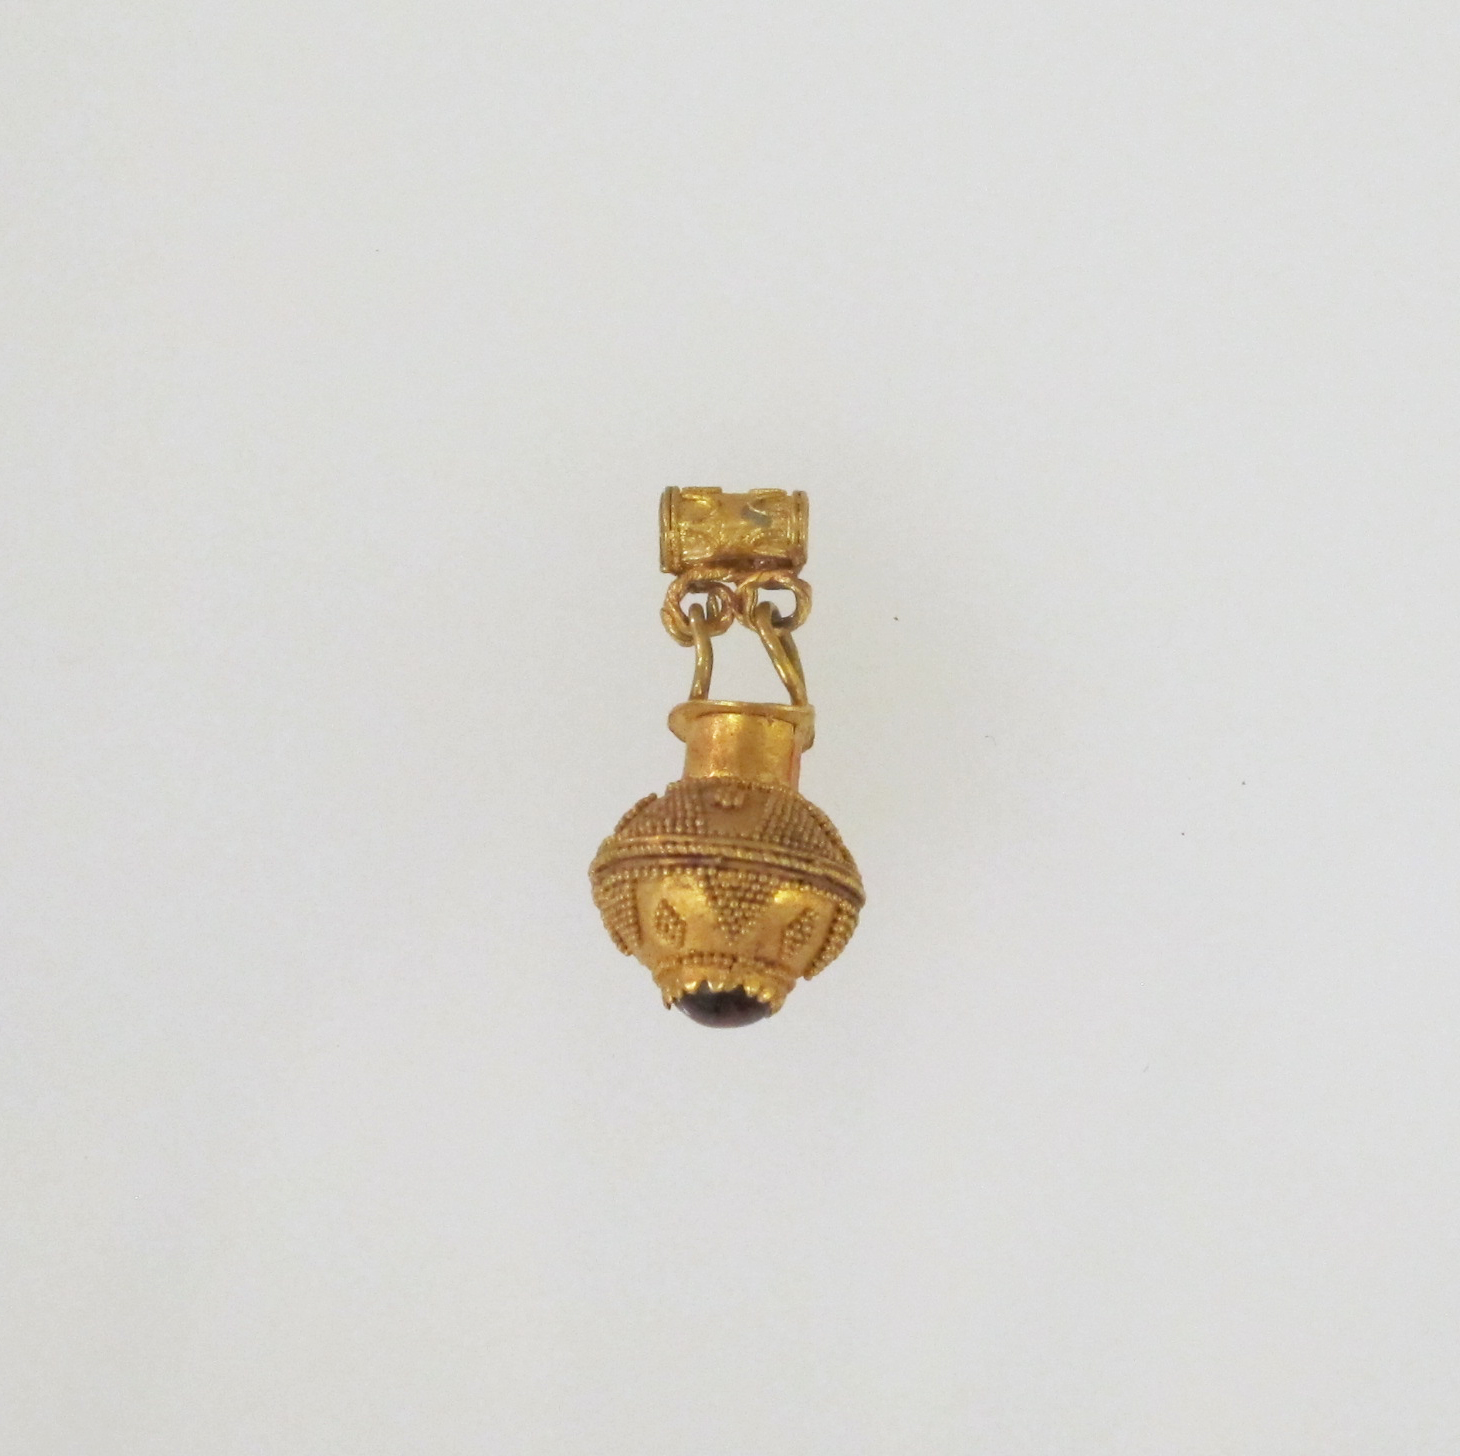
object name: earring in the form of a vase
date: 400-201 BCE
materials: gemstone, gold